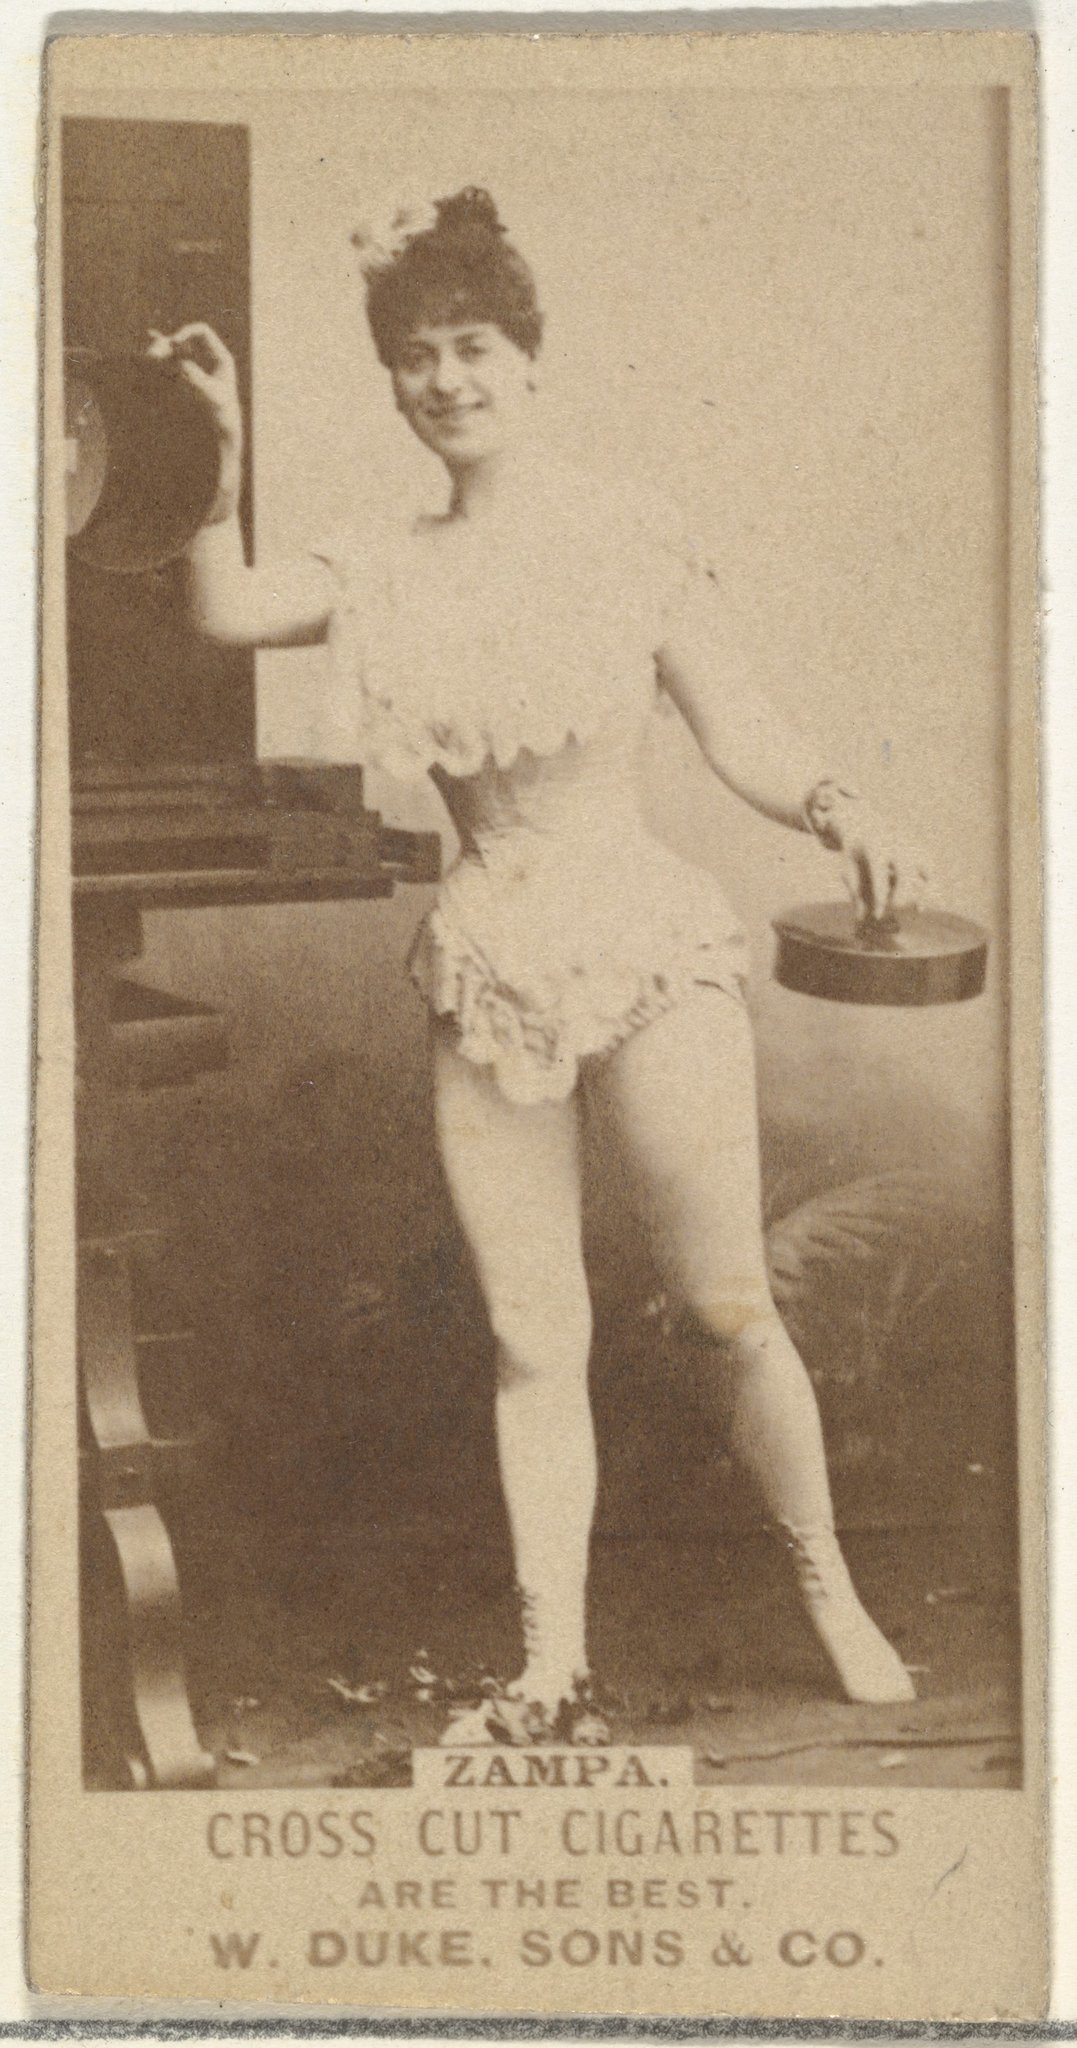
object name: photograph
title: Zampa, from the Actors and Actresses series (N145-3) issued by Duke Sons & Co. to promote Cross Cut Cigarettes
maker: w. duke, sons & co.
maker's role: publisher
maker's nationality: american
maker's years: 1870-1920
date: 1880-1889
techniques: albumen silver print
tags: portraits,women,actresses